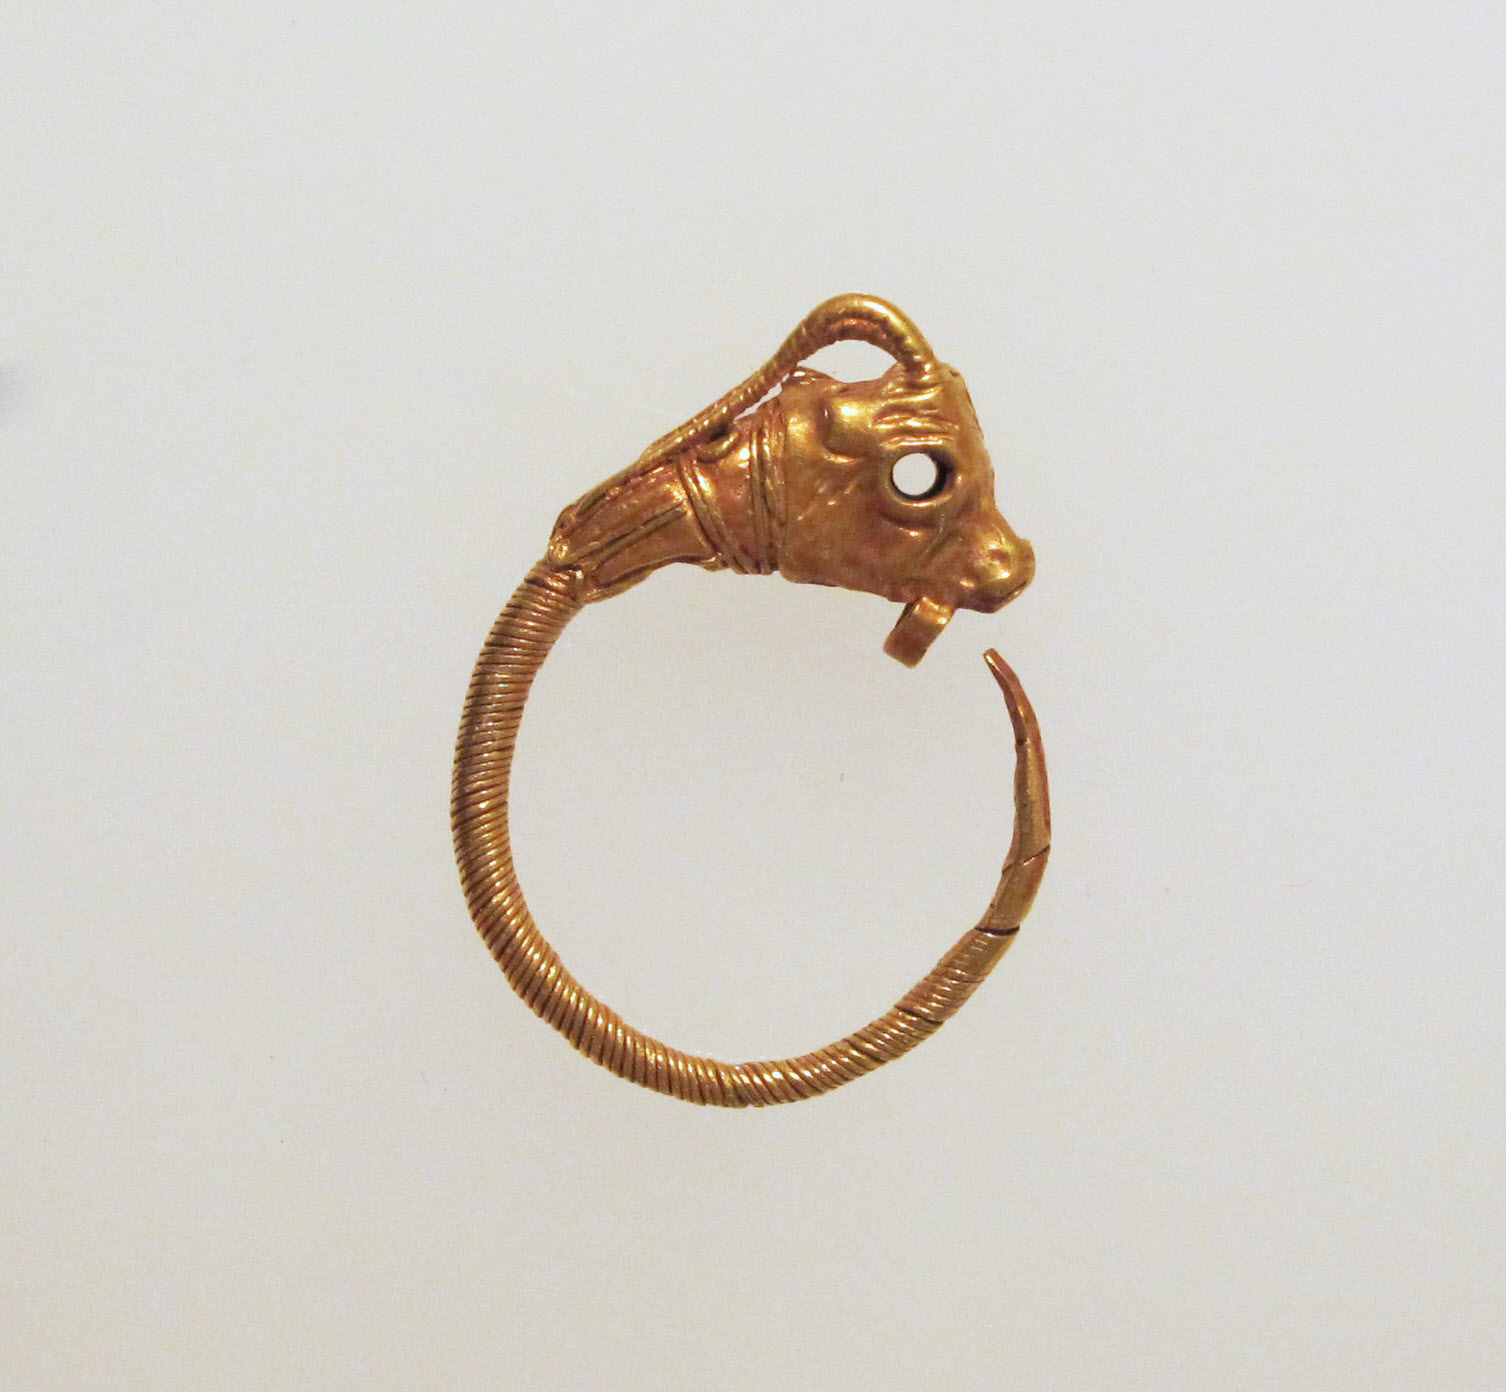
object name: earring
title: Gold earring with head of a goat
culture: greek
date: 200-101 BCE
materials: gold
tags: goats